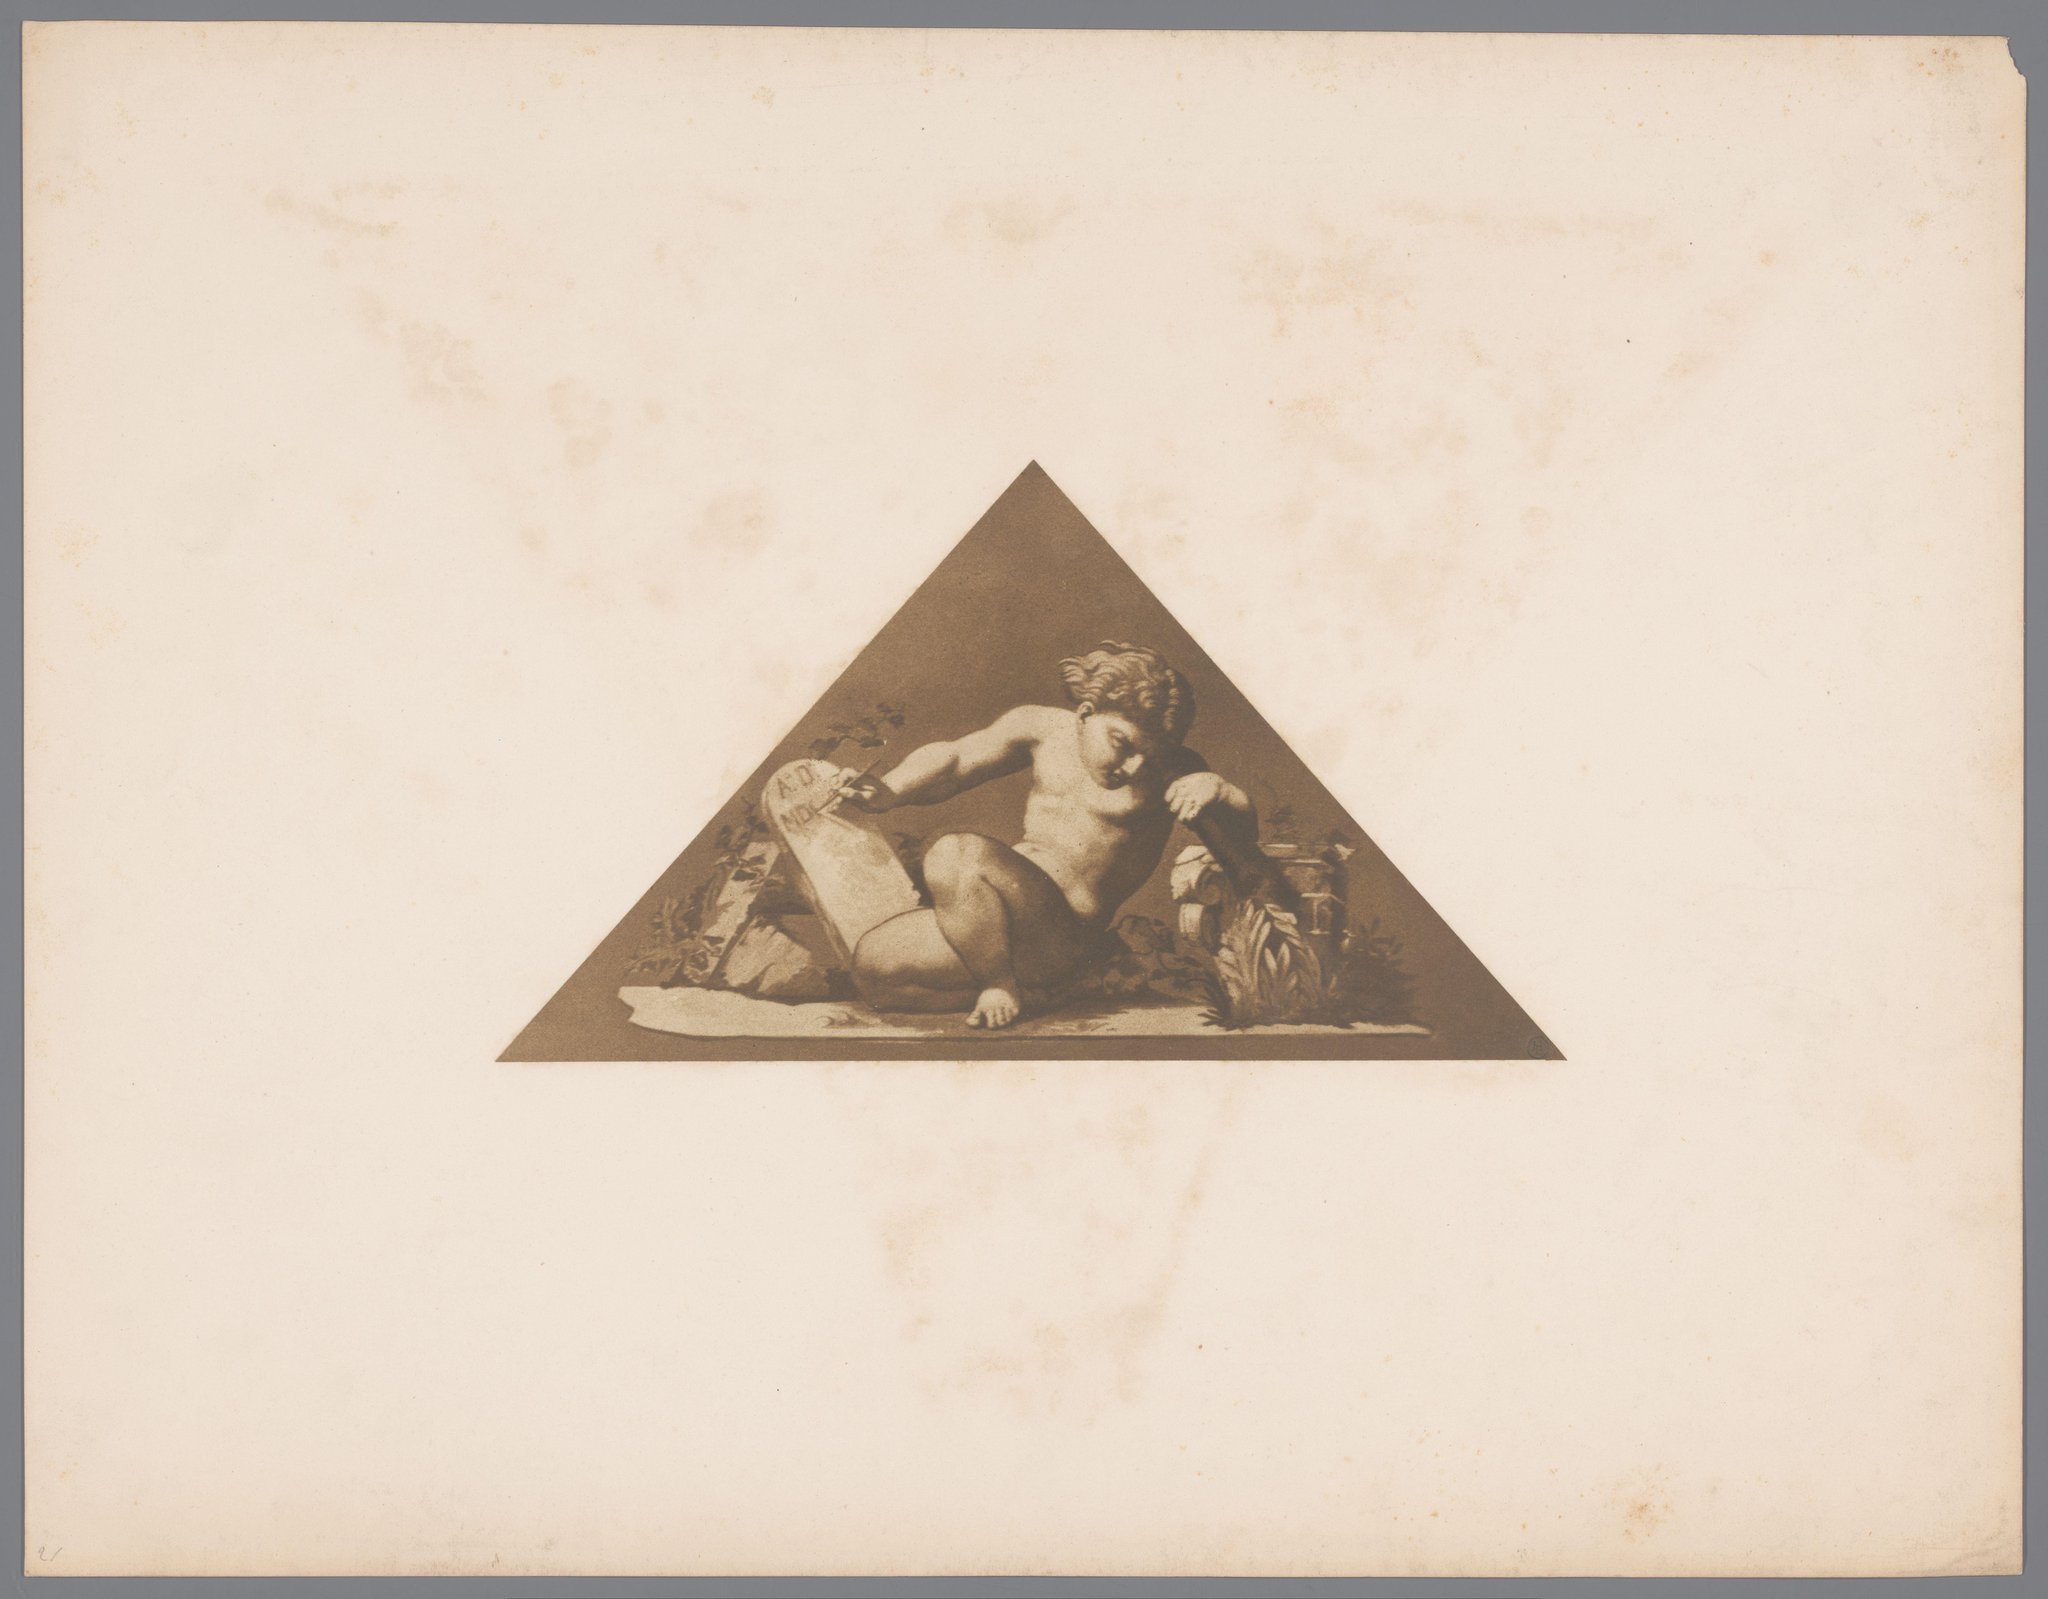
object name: photograph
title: Fotografische reproductie van decoratie aan plafond, Hotel de Ville, Parijs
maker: gustave le gray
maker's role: fotograaf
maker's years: 1820-1884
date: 1852-1853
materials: cardboard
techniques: salted paper print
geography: paris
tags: paris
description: Maakt onderdeel uit van een serie van 18 bladen met foto's van de cartons voor de plafondschilderingen door Henri Lehmann voor de Galerie des Fêtes in het Hotel de Ville, Parijs.